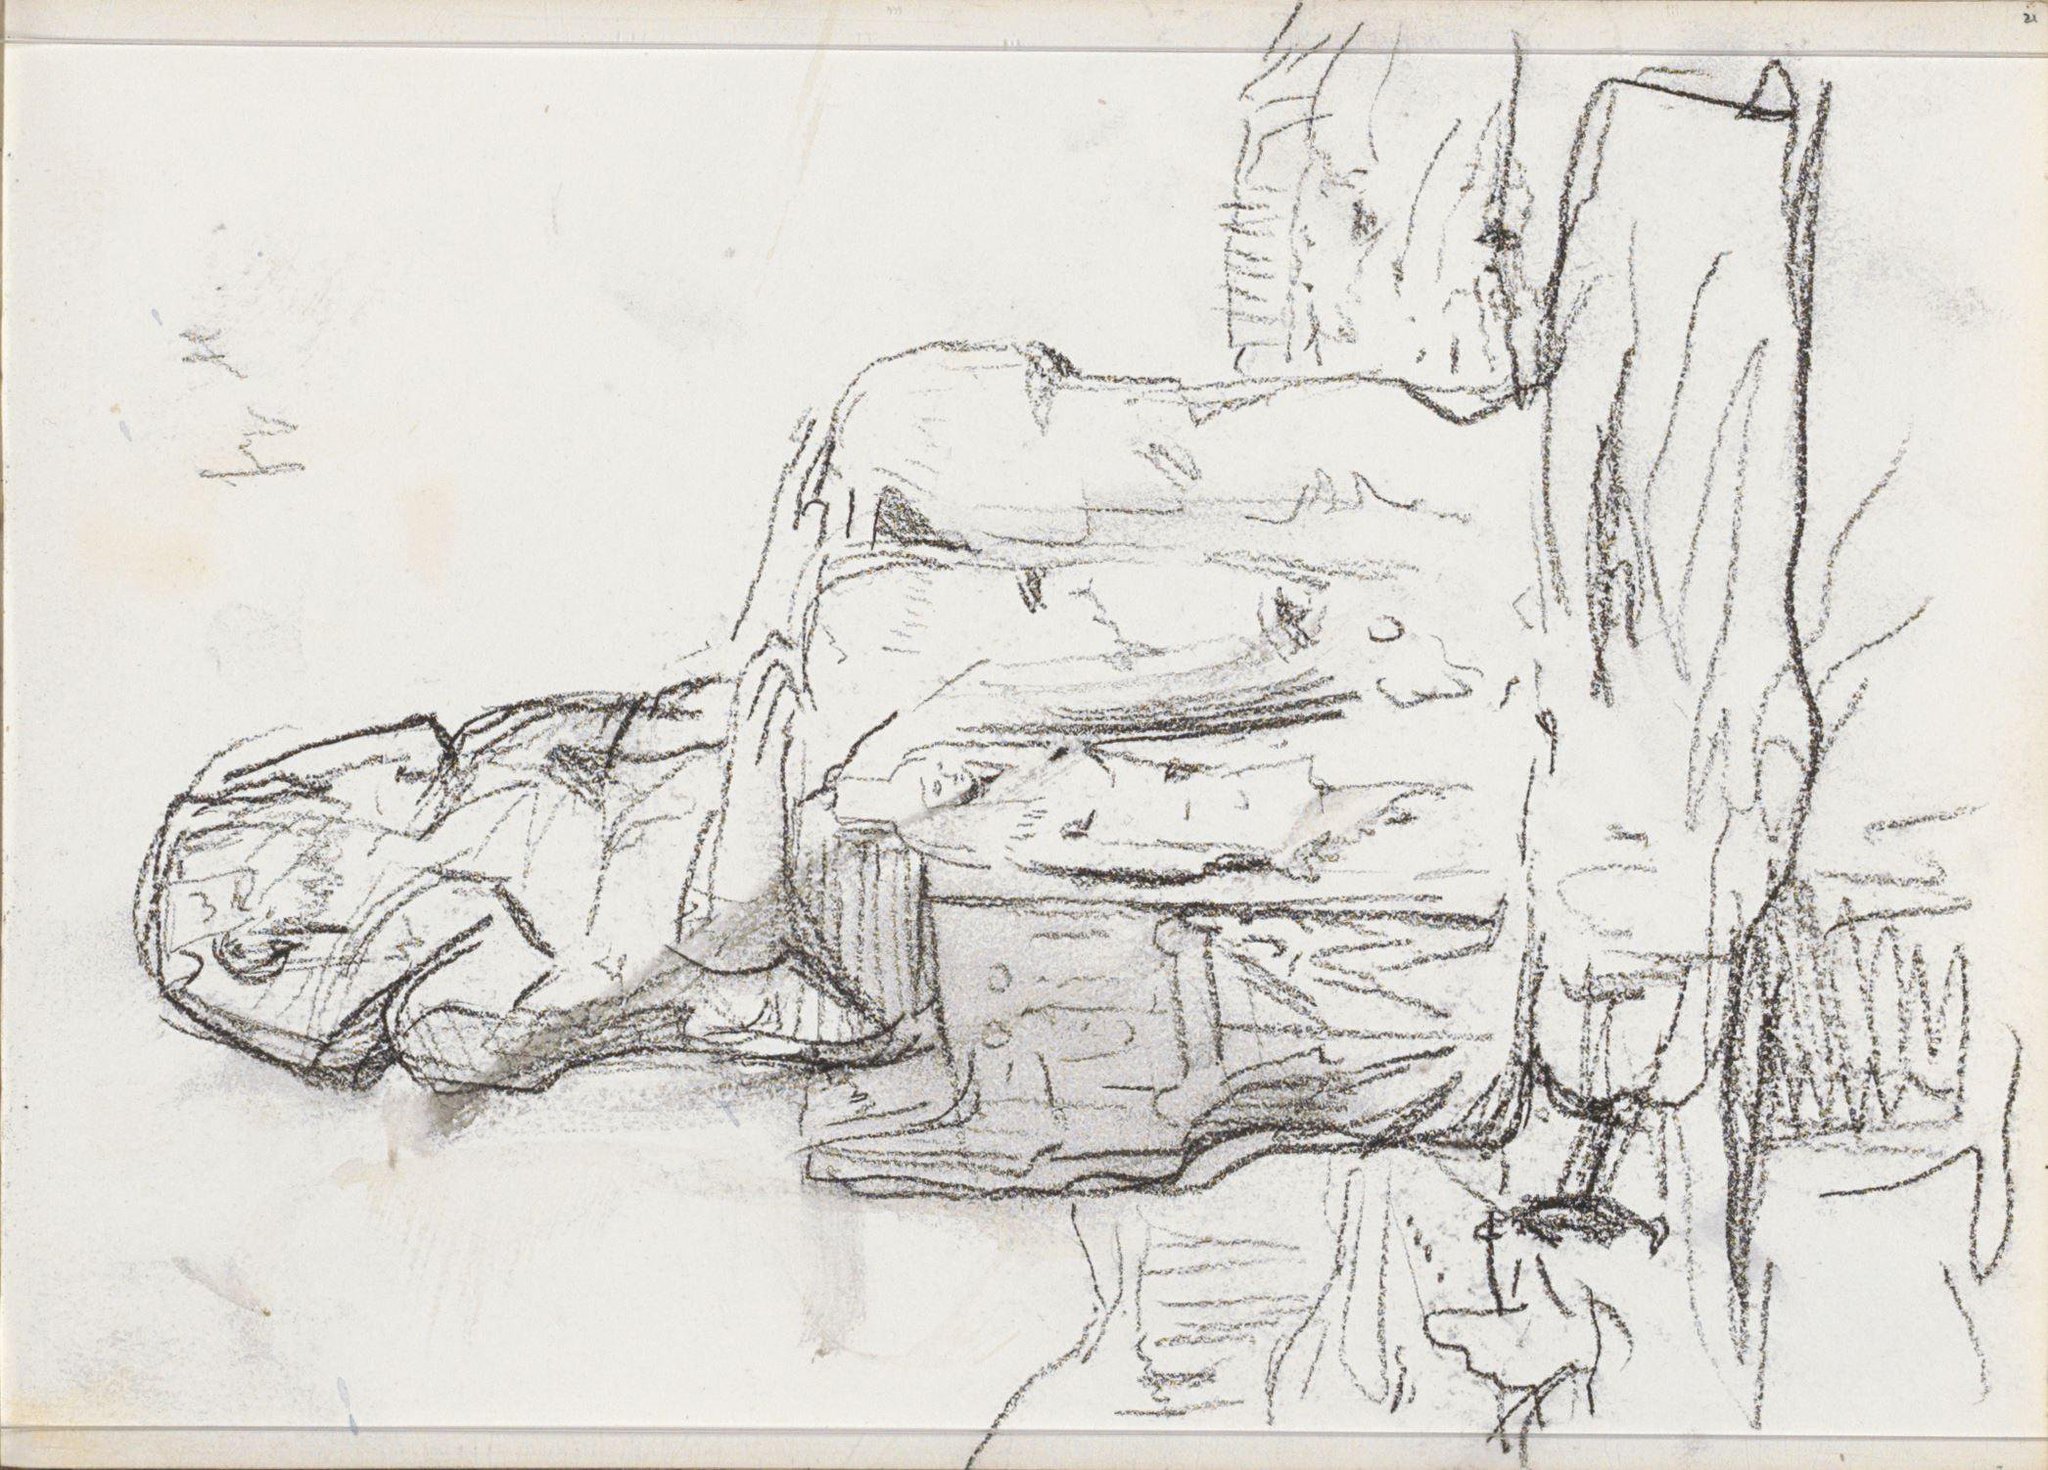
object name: sketchbook leaf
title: Beeldhouwwerk van de zittende Ramses II bij de Luxortempel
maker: marius bauer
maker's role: draughtsman, print maker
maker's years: 1867-1932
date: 1919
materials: chalk, paper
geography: luxor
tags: temple, shrine ~ egyptian religion, sculpture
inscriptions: kleurnotitie, handgeschreven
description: Standbeeld van Amenhotep III, een van de Kolossen van Memnon bij nabij Luxor. Pagina 21 uit een schetsboek met 23 bladen.